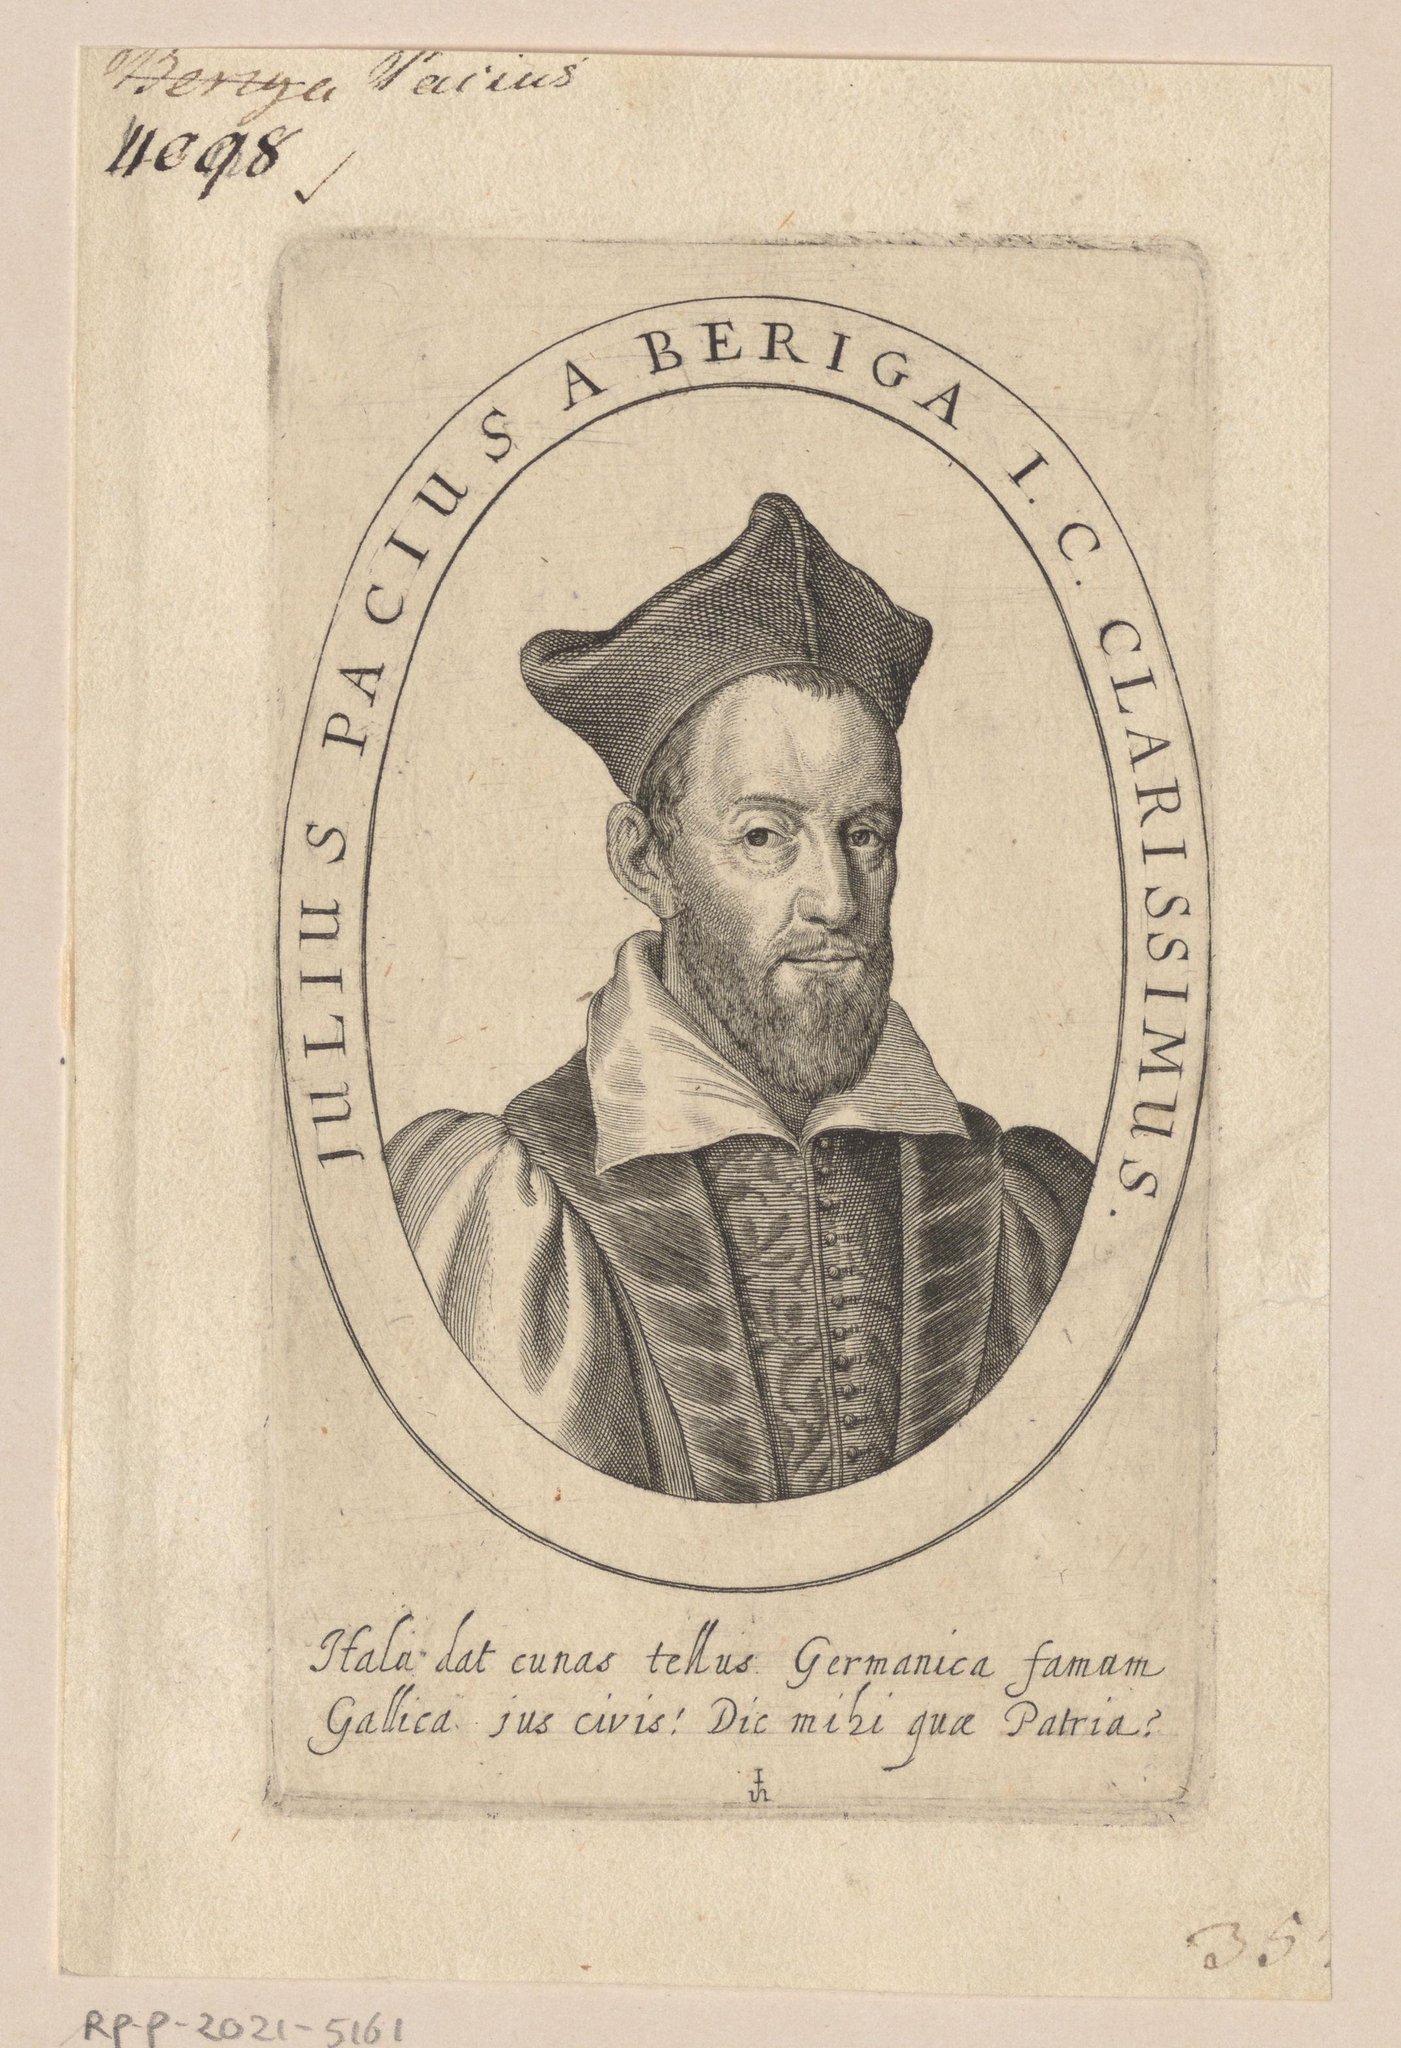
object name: print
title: Portret van Giulio Pace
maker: jacob van der heyden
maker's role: draughtsman, print maker, publisher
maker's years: 1573-1645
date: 1601-1633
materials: paper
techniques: engraving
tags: adult man, historical persons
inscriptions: monogram: ‘Jh’, inscription: ‘Beriga Pacius/ [?]98’